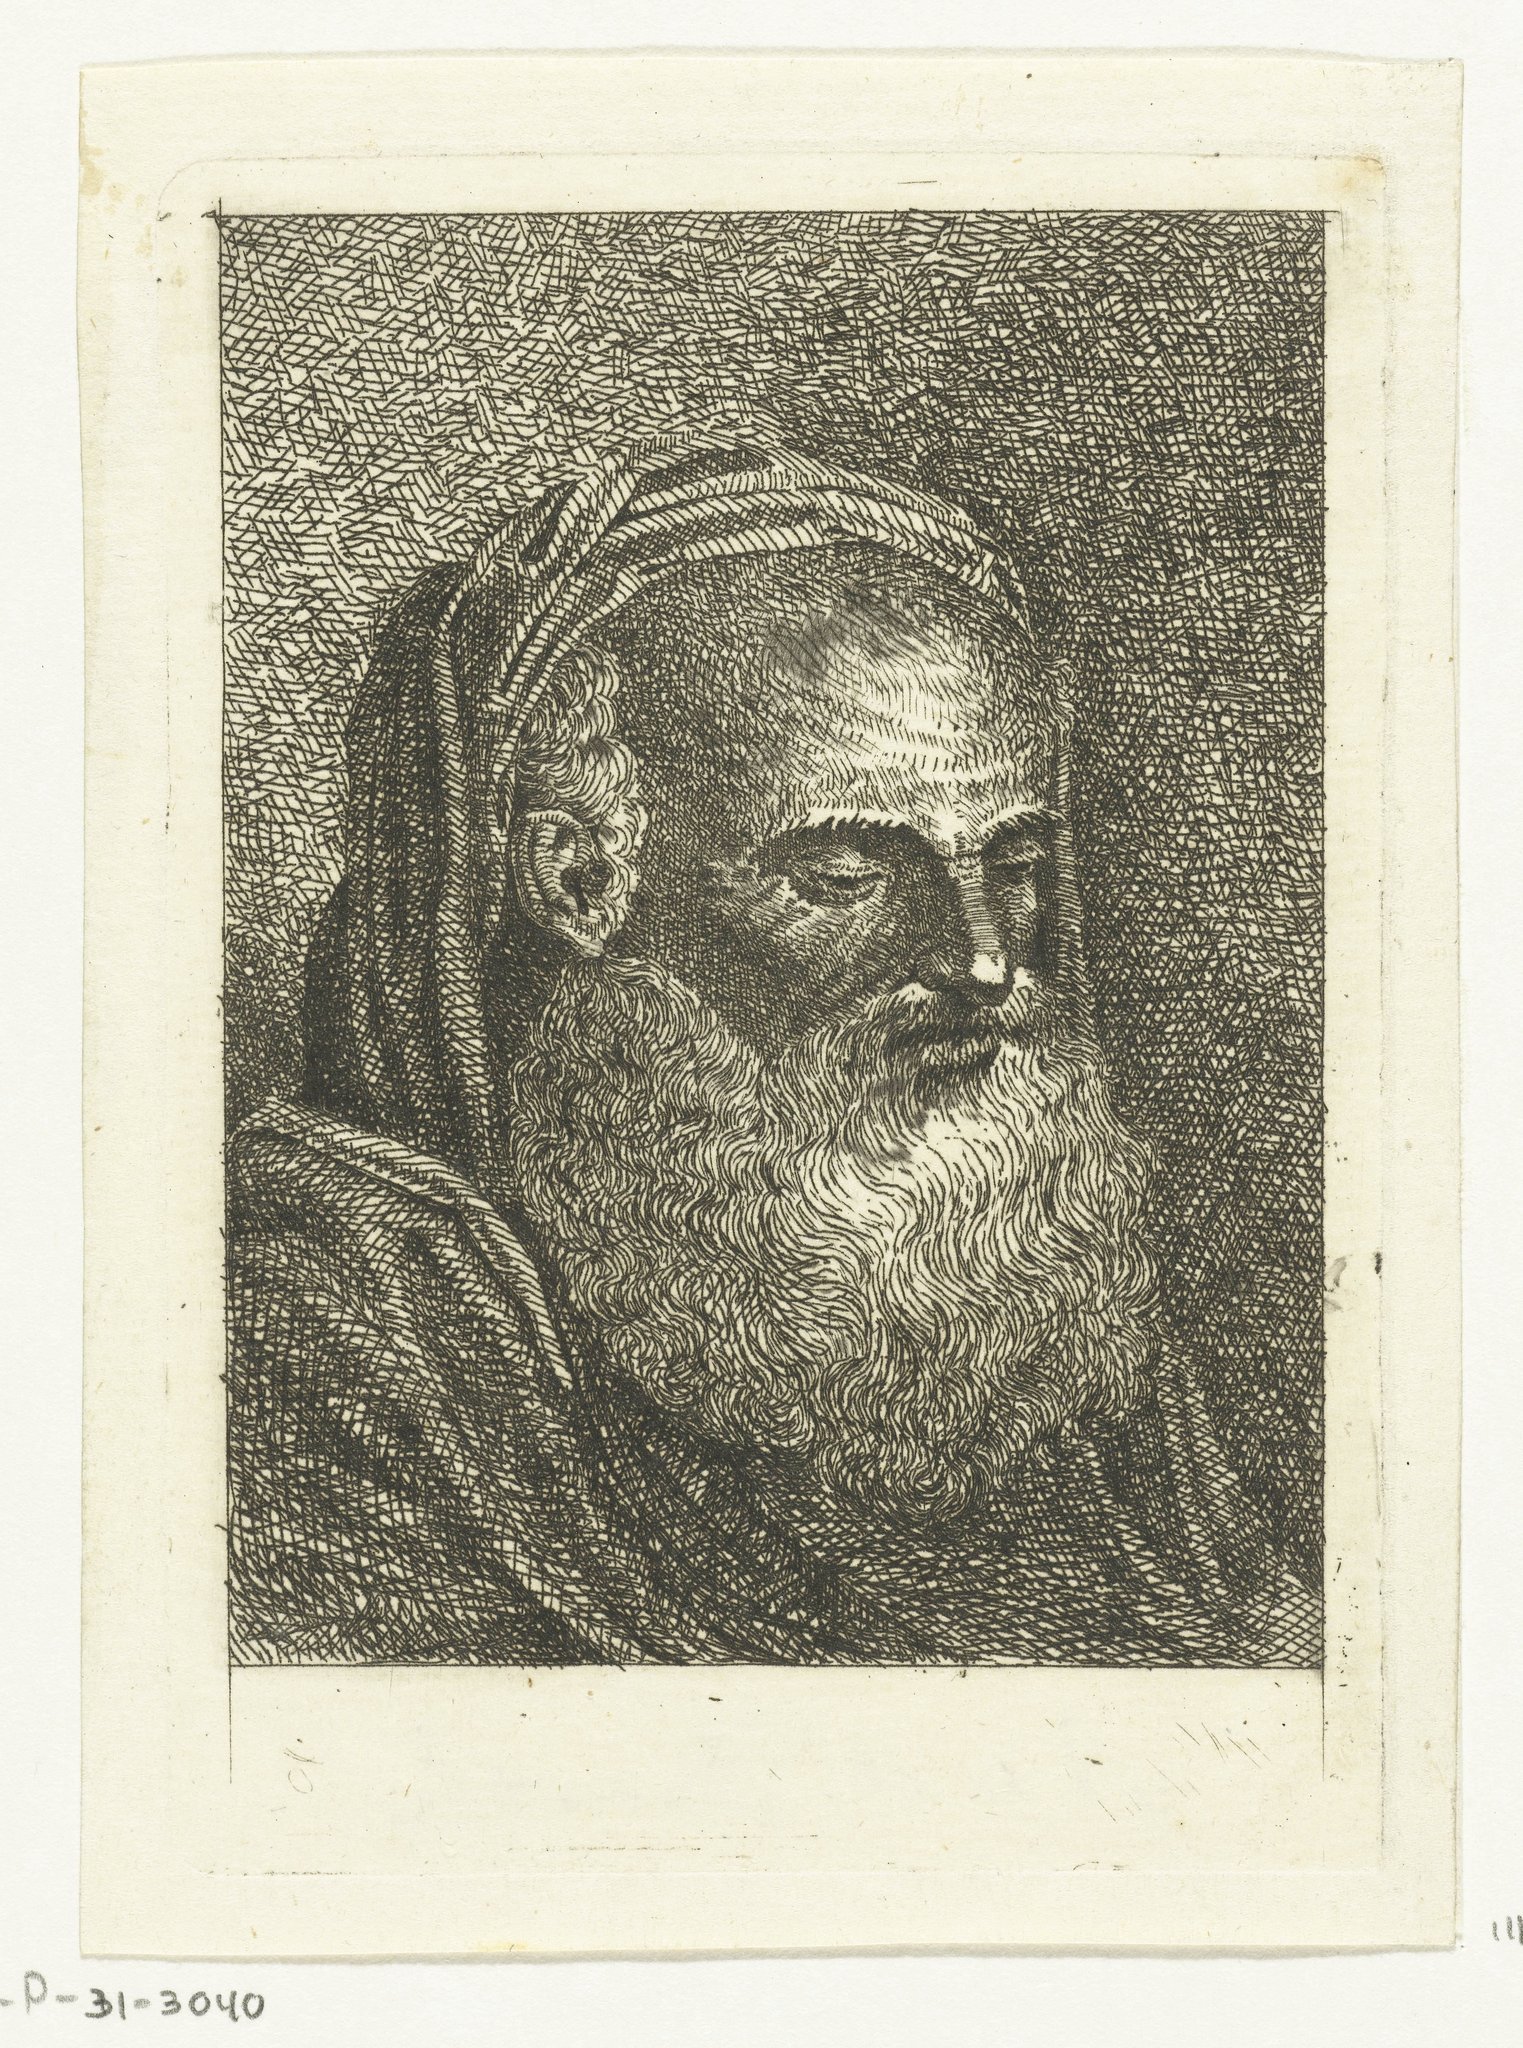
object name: print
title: Borstbeeld van een oude man met witte baard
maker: anthonie van den bos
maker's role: draughtsman, print maker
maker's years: 1763-1838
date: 1778-1838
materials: paper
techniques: etching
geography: netherlands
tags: old man (+ three-quarter view)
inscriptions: collector's mark: Lugt 2228